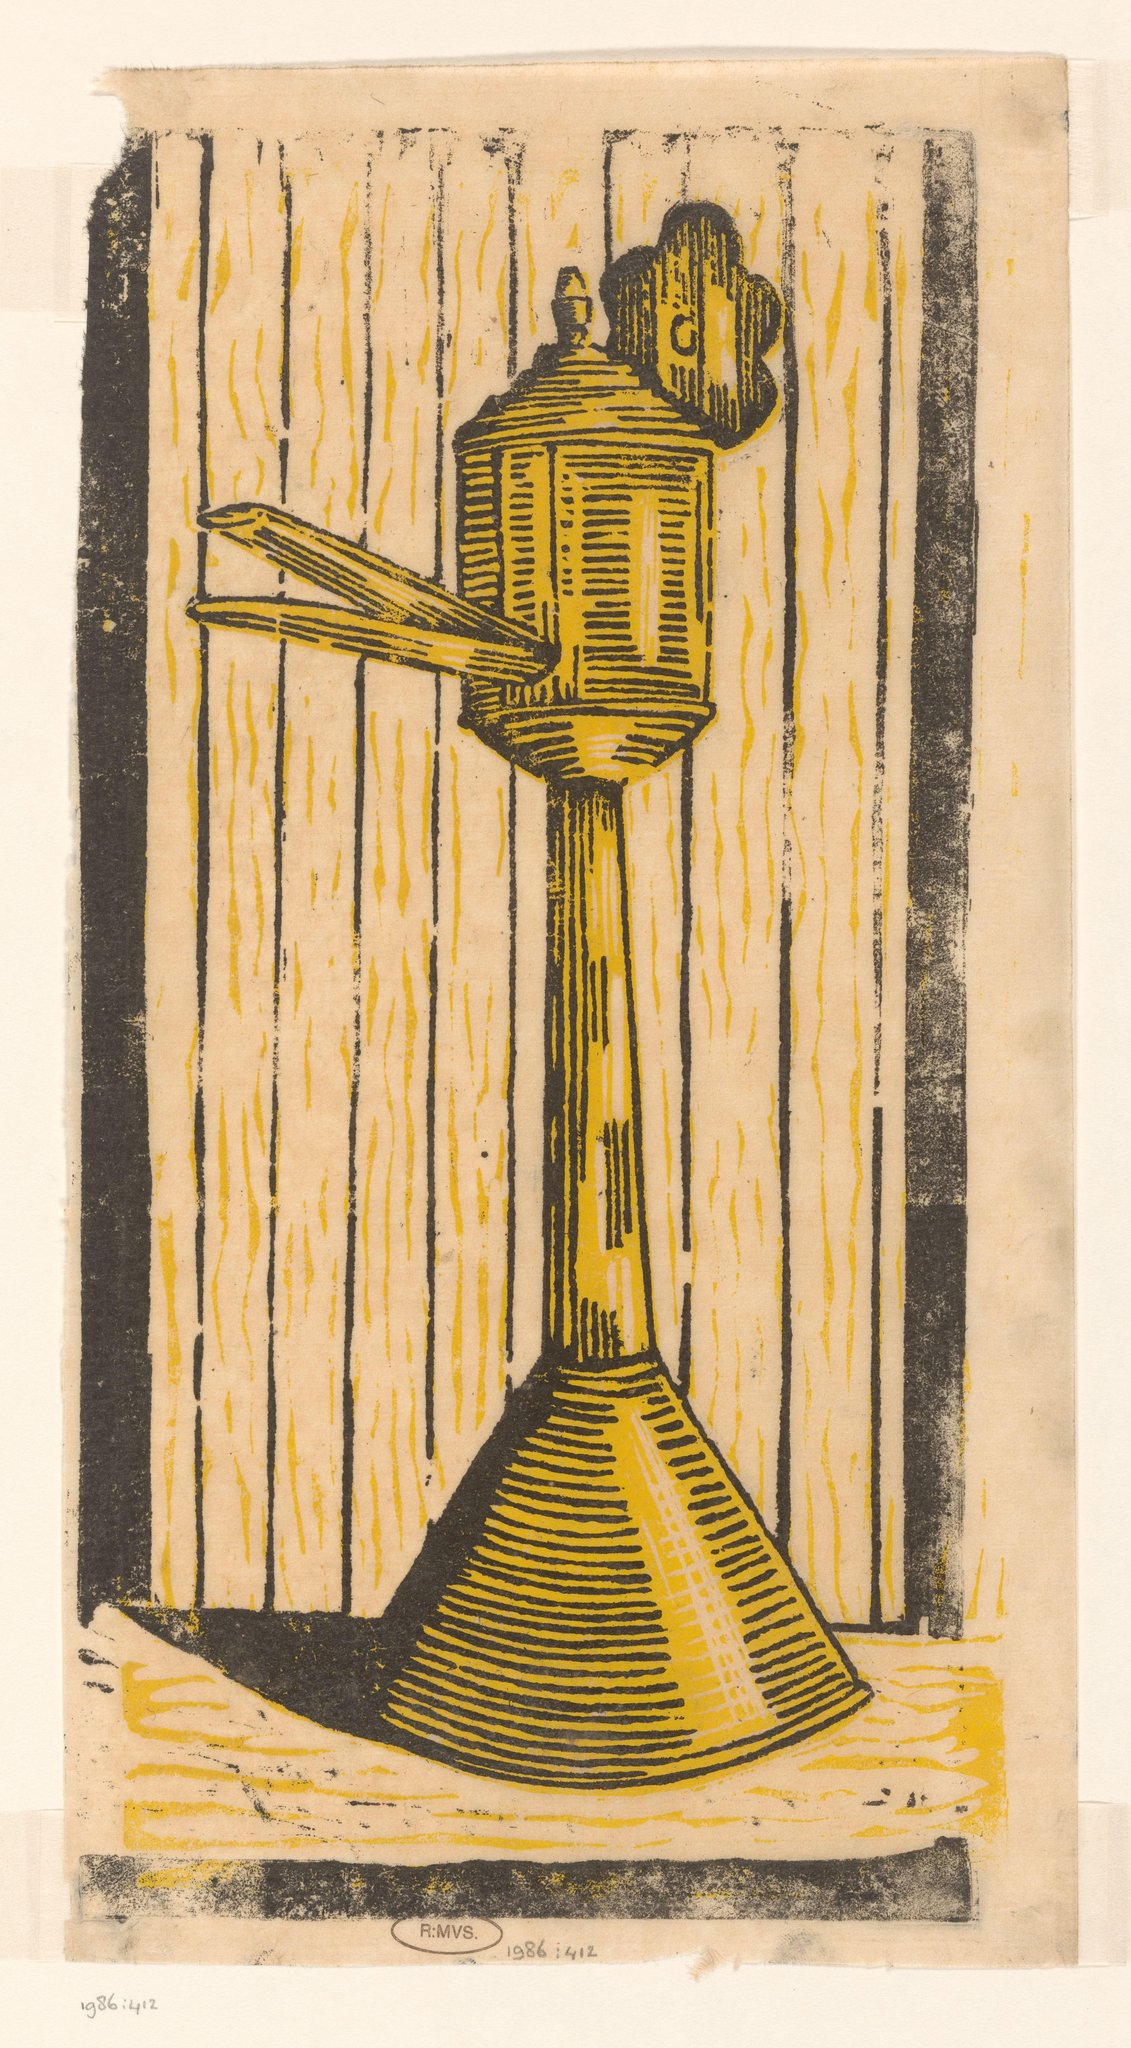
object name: print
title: Lantaarn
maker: reinier willem petrus de vries (1874-1953)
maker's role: draughtsman, print maker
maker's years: 1874-1953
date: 1884-1952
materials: paper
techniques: linocut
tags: lantern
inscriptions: collector's mark: Lugt 2228